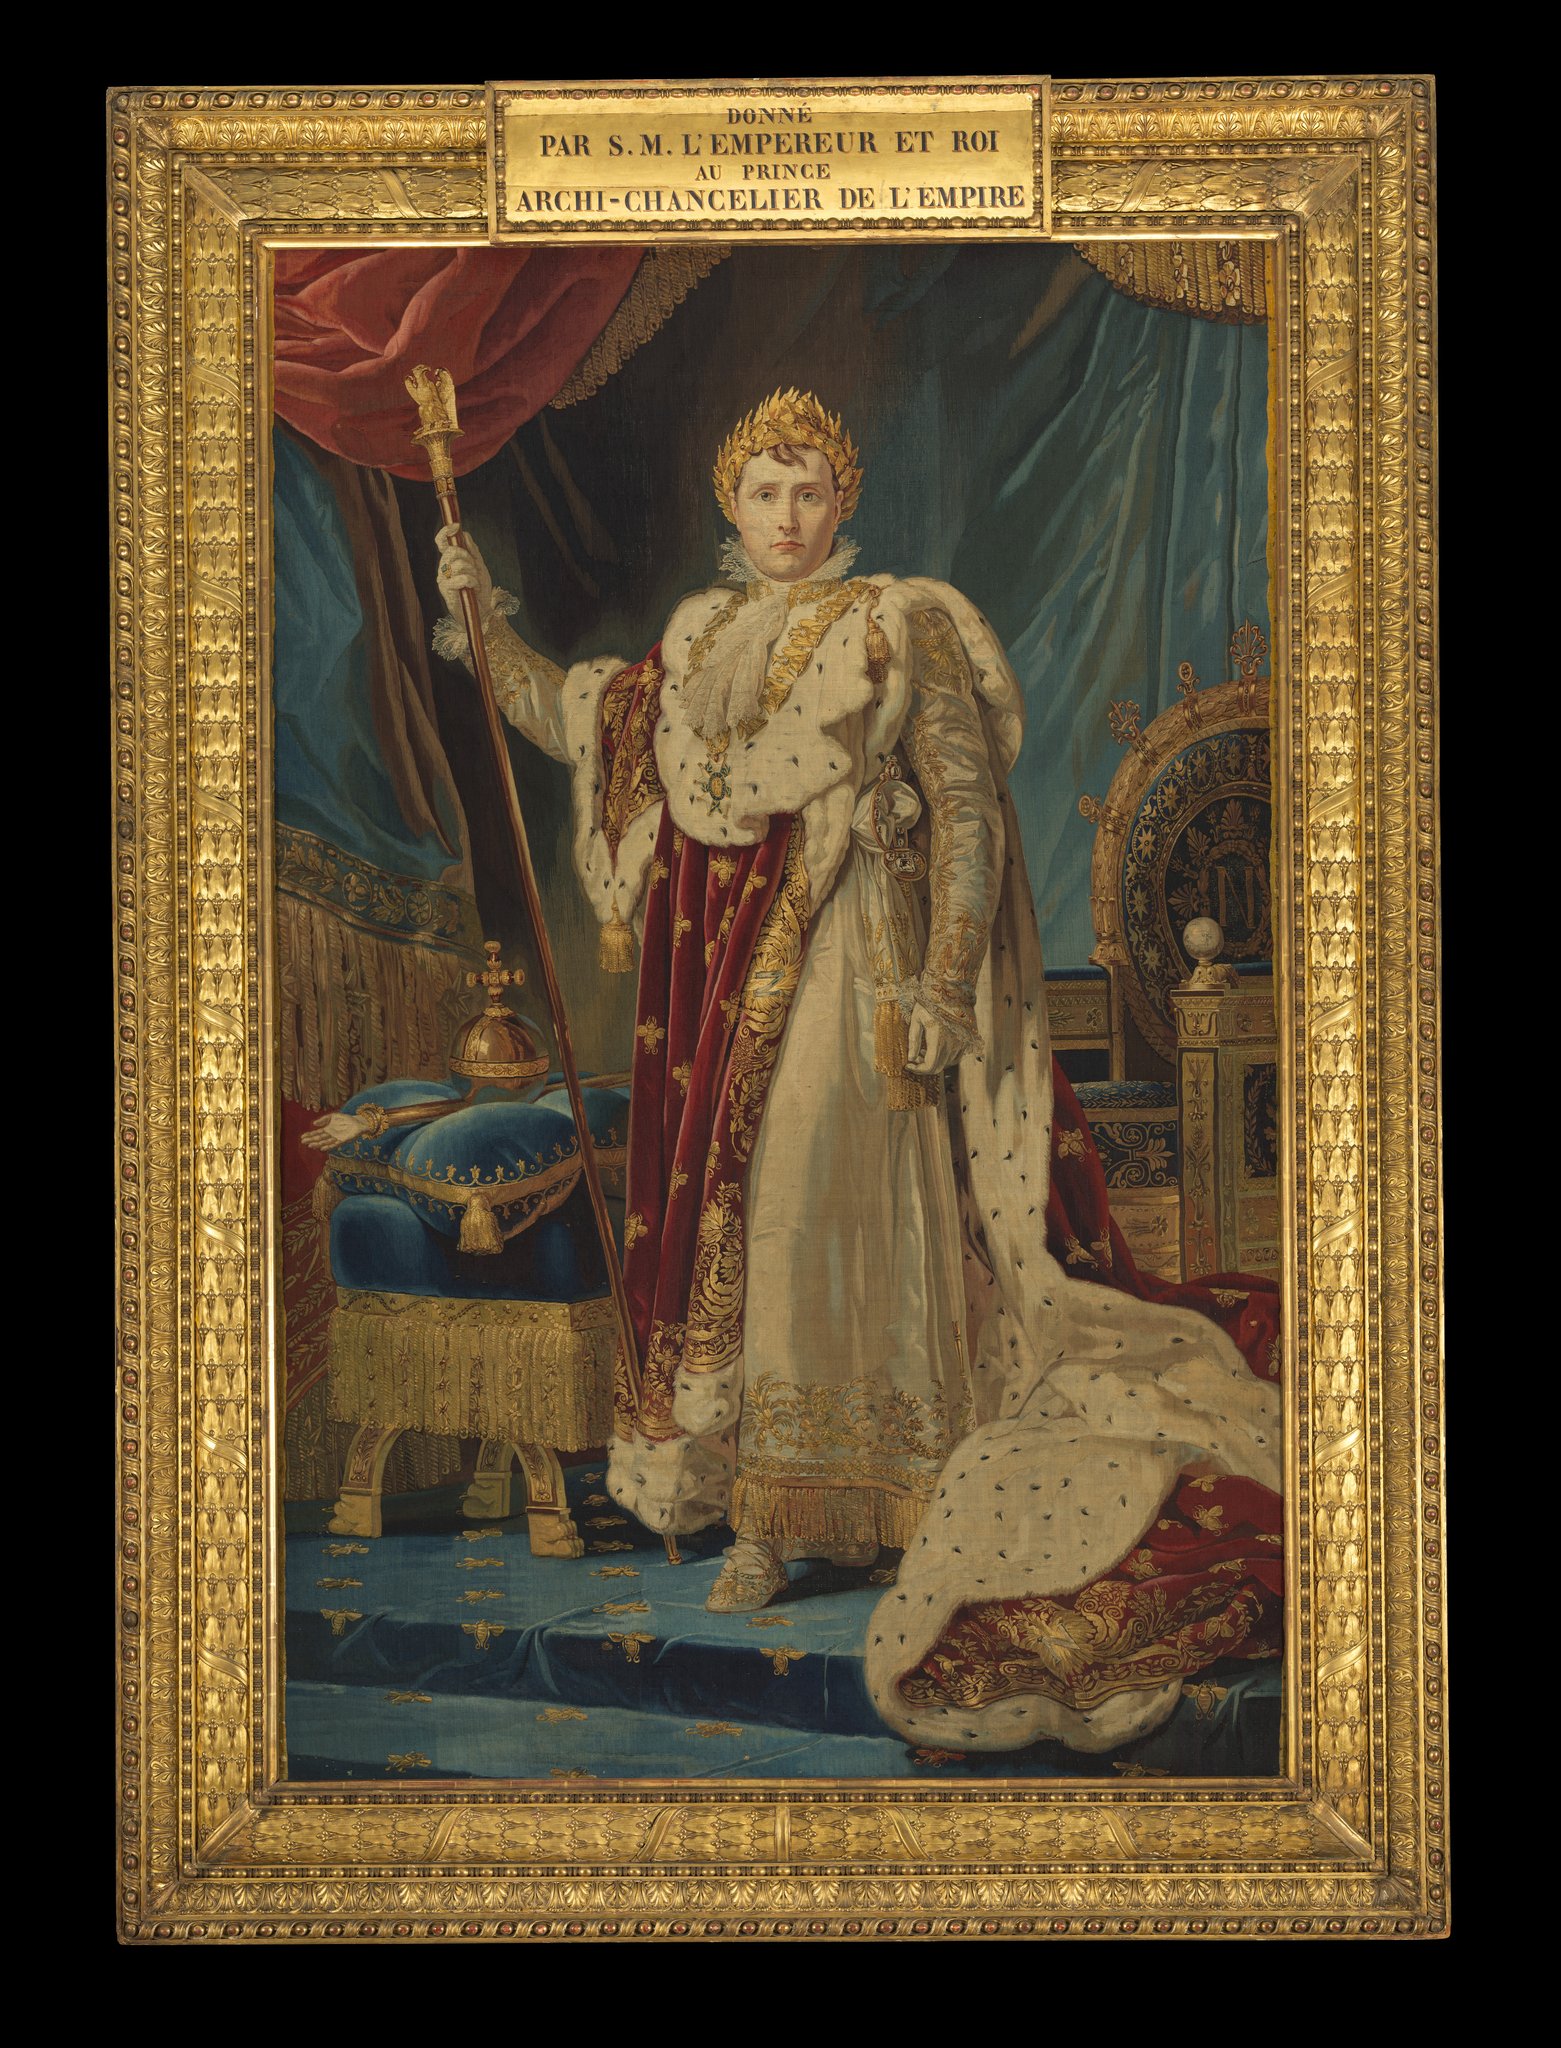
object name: tapestry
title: Portrait of Napoleon I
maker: baron françois gérard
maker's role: artist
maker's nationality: french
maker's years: 1770-1837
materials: wood, silk, silver gilt, thread, wool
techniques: gilding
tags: napoleon i,men,portraits